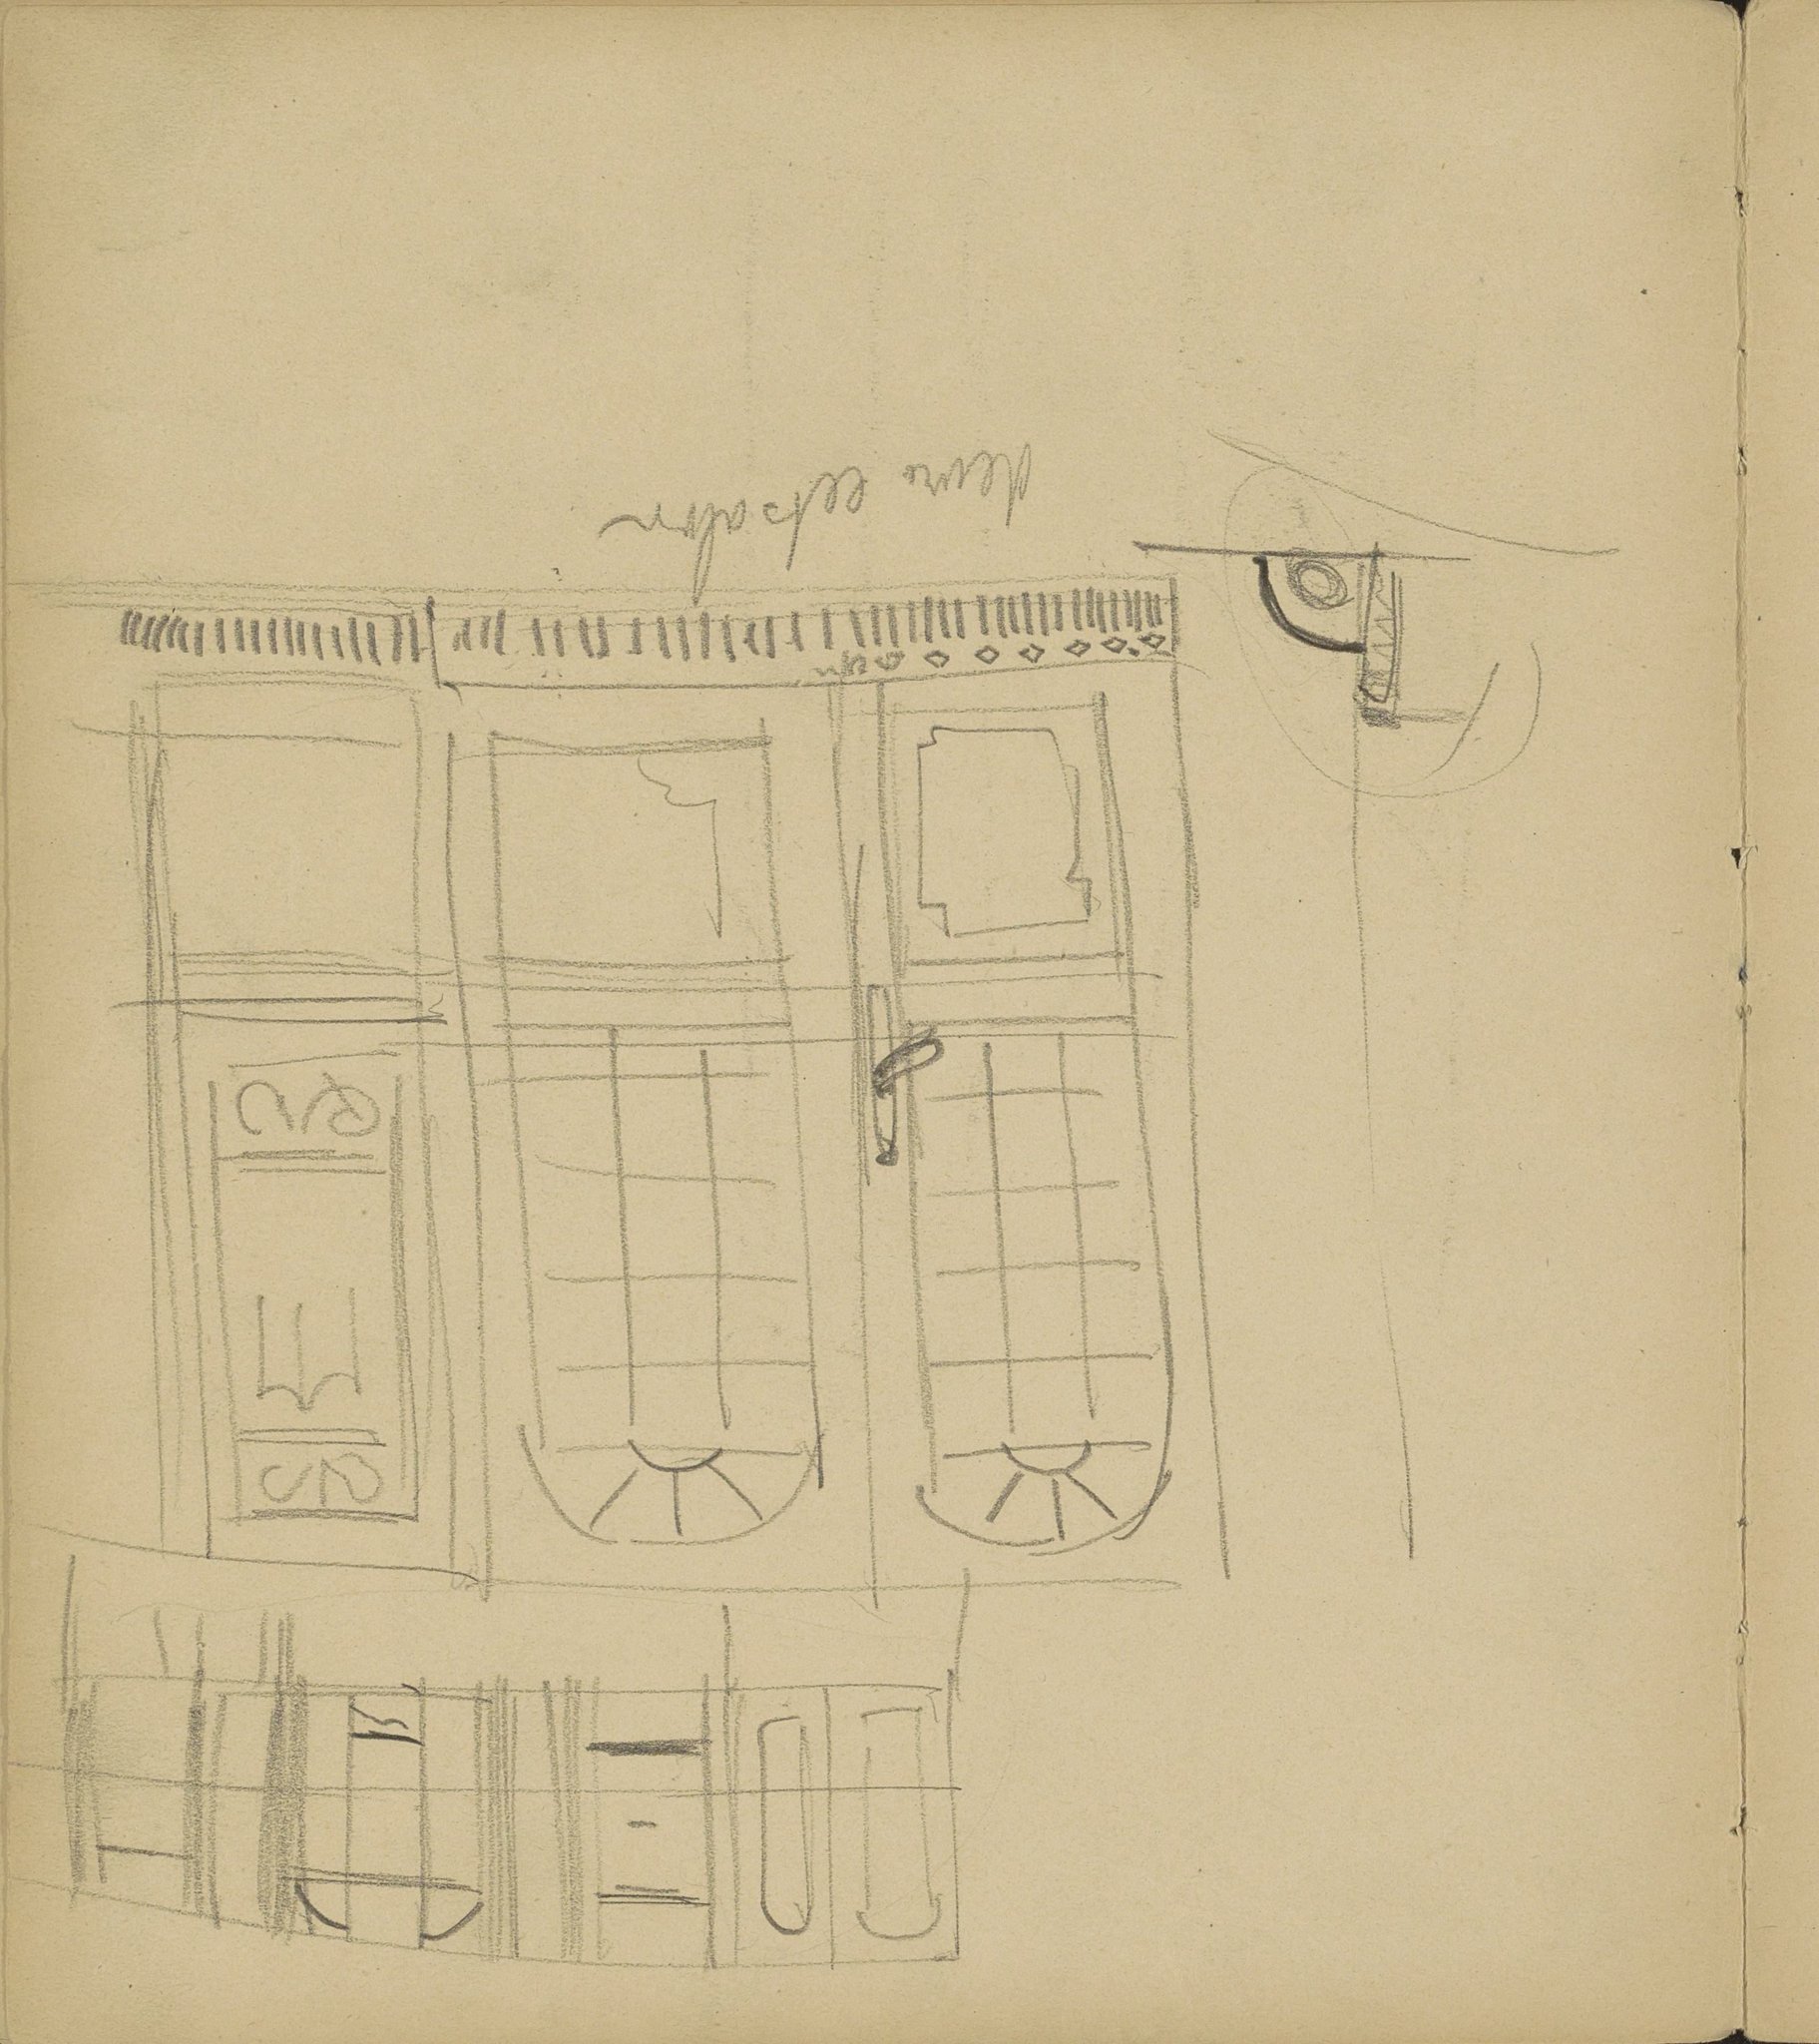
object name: sketchbook leaf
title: Ontwerp voor de deuren van de eetsalon van het schip 'Grotius'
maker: carel adolph lion cachet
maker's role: draughtsman, print maker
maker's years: 1864-1945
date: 1906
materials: paper, pencil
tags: door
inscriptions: annotation: ‘deuren eetsalon’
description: Blad 4 verso uit een schetsboek met 27 bladen.